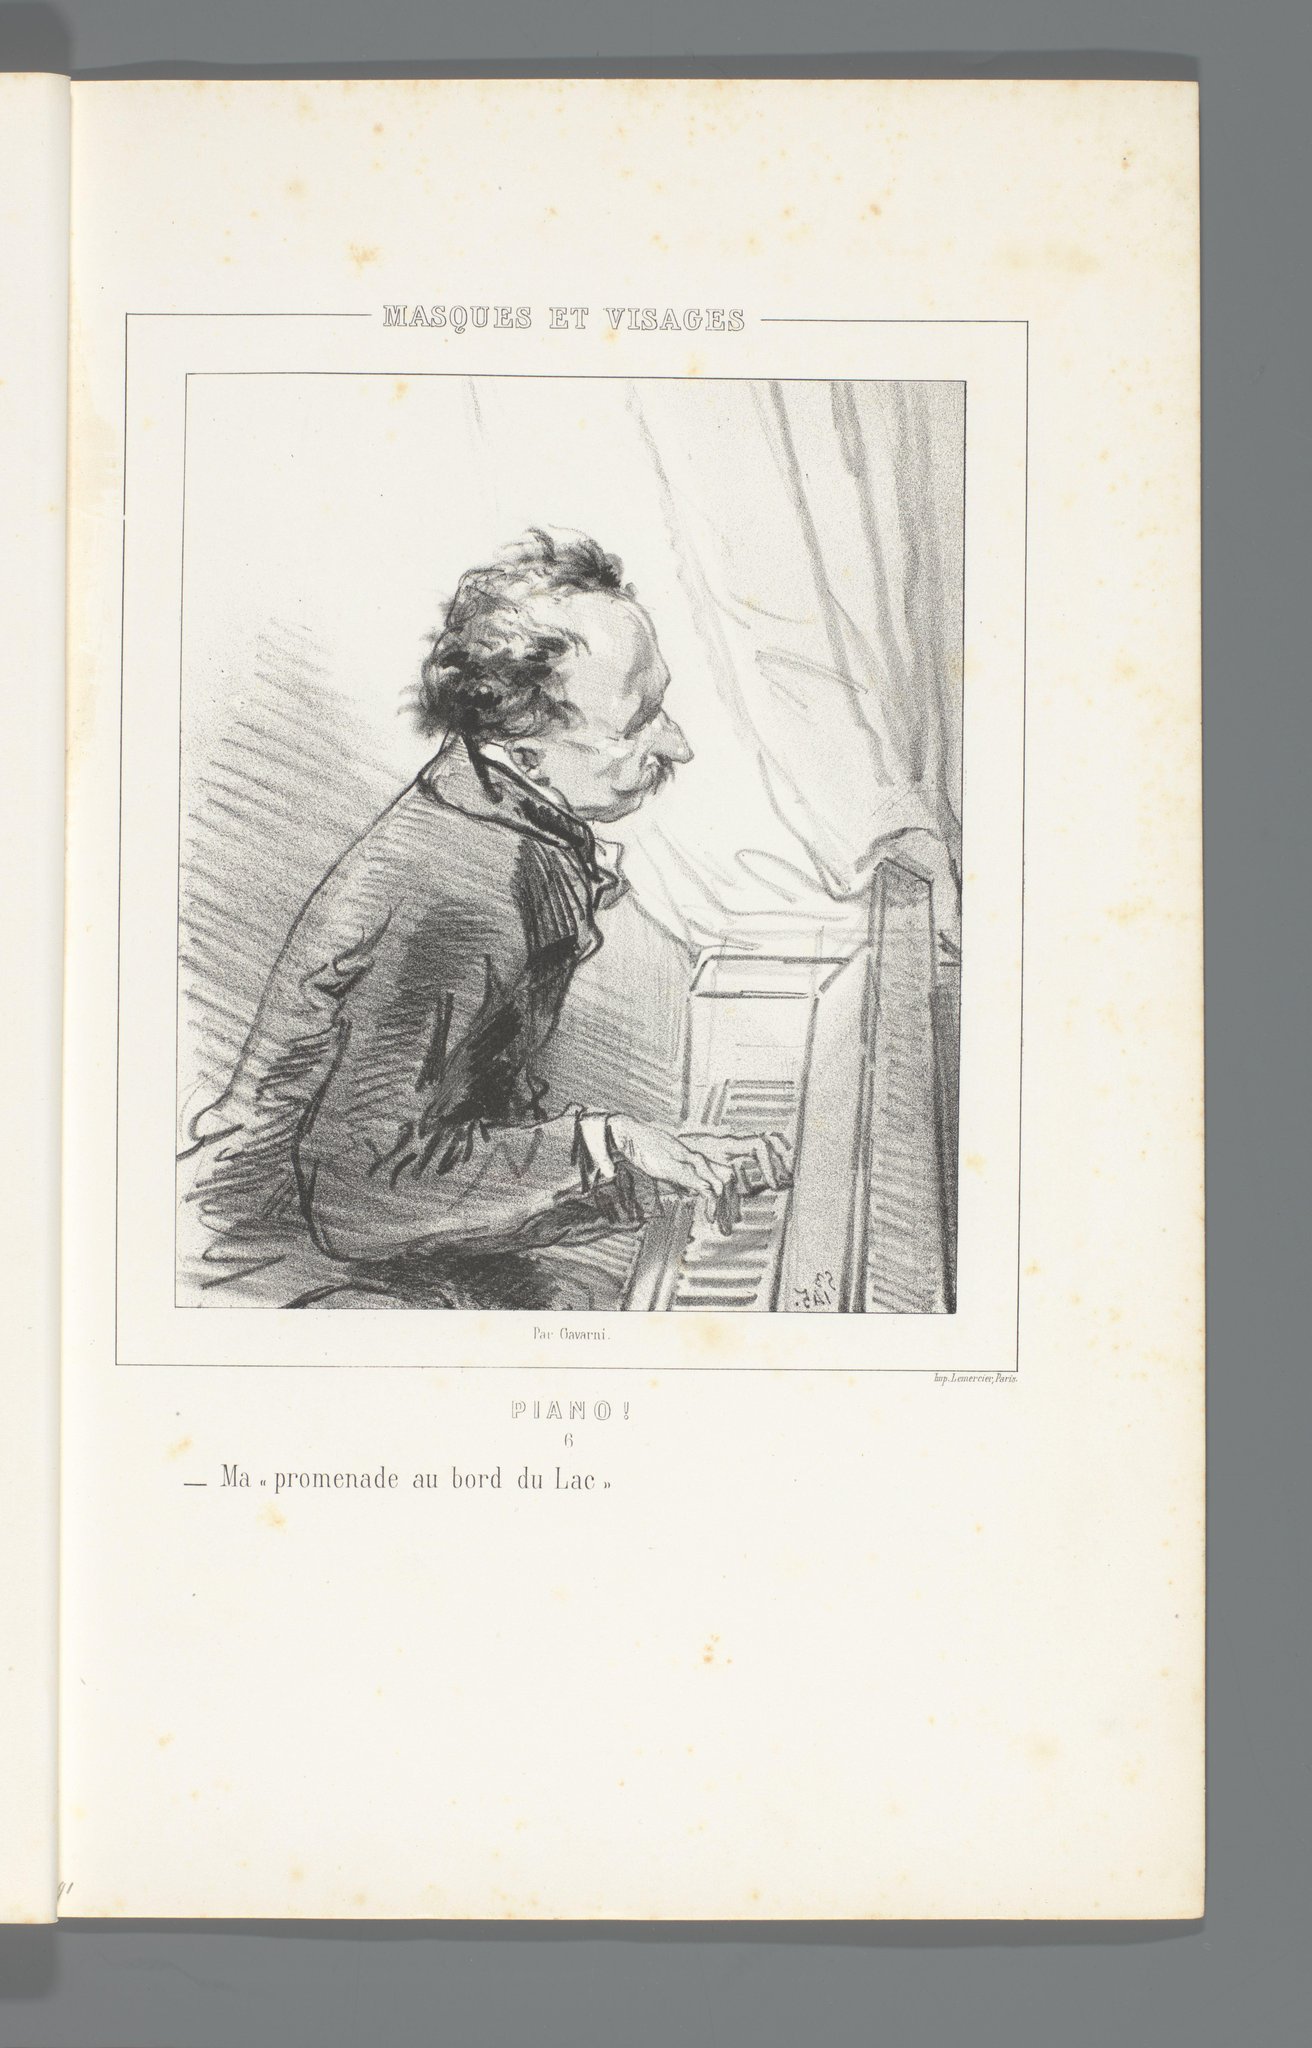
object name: cartoon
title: Pianist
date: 1853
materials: paper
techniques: lithograph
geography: paris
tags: one person playing keyboard instrument, pianoforte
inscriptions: collector's mark: Lugt 964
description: Prent gebruikt voor: Paris (journal), 6 juli 1853.